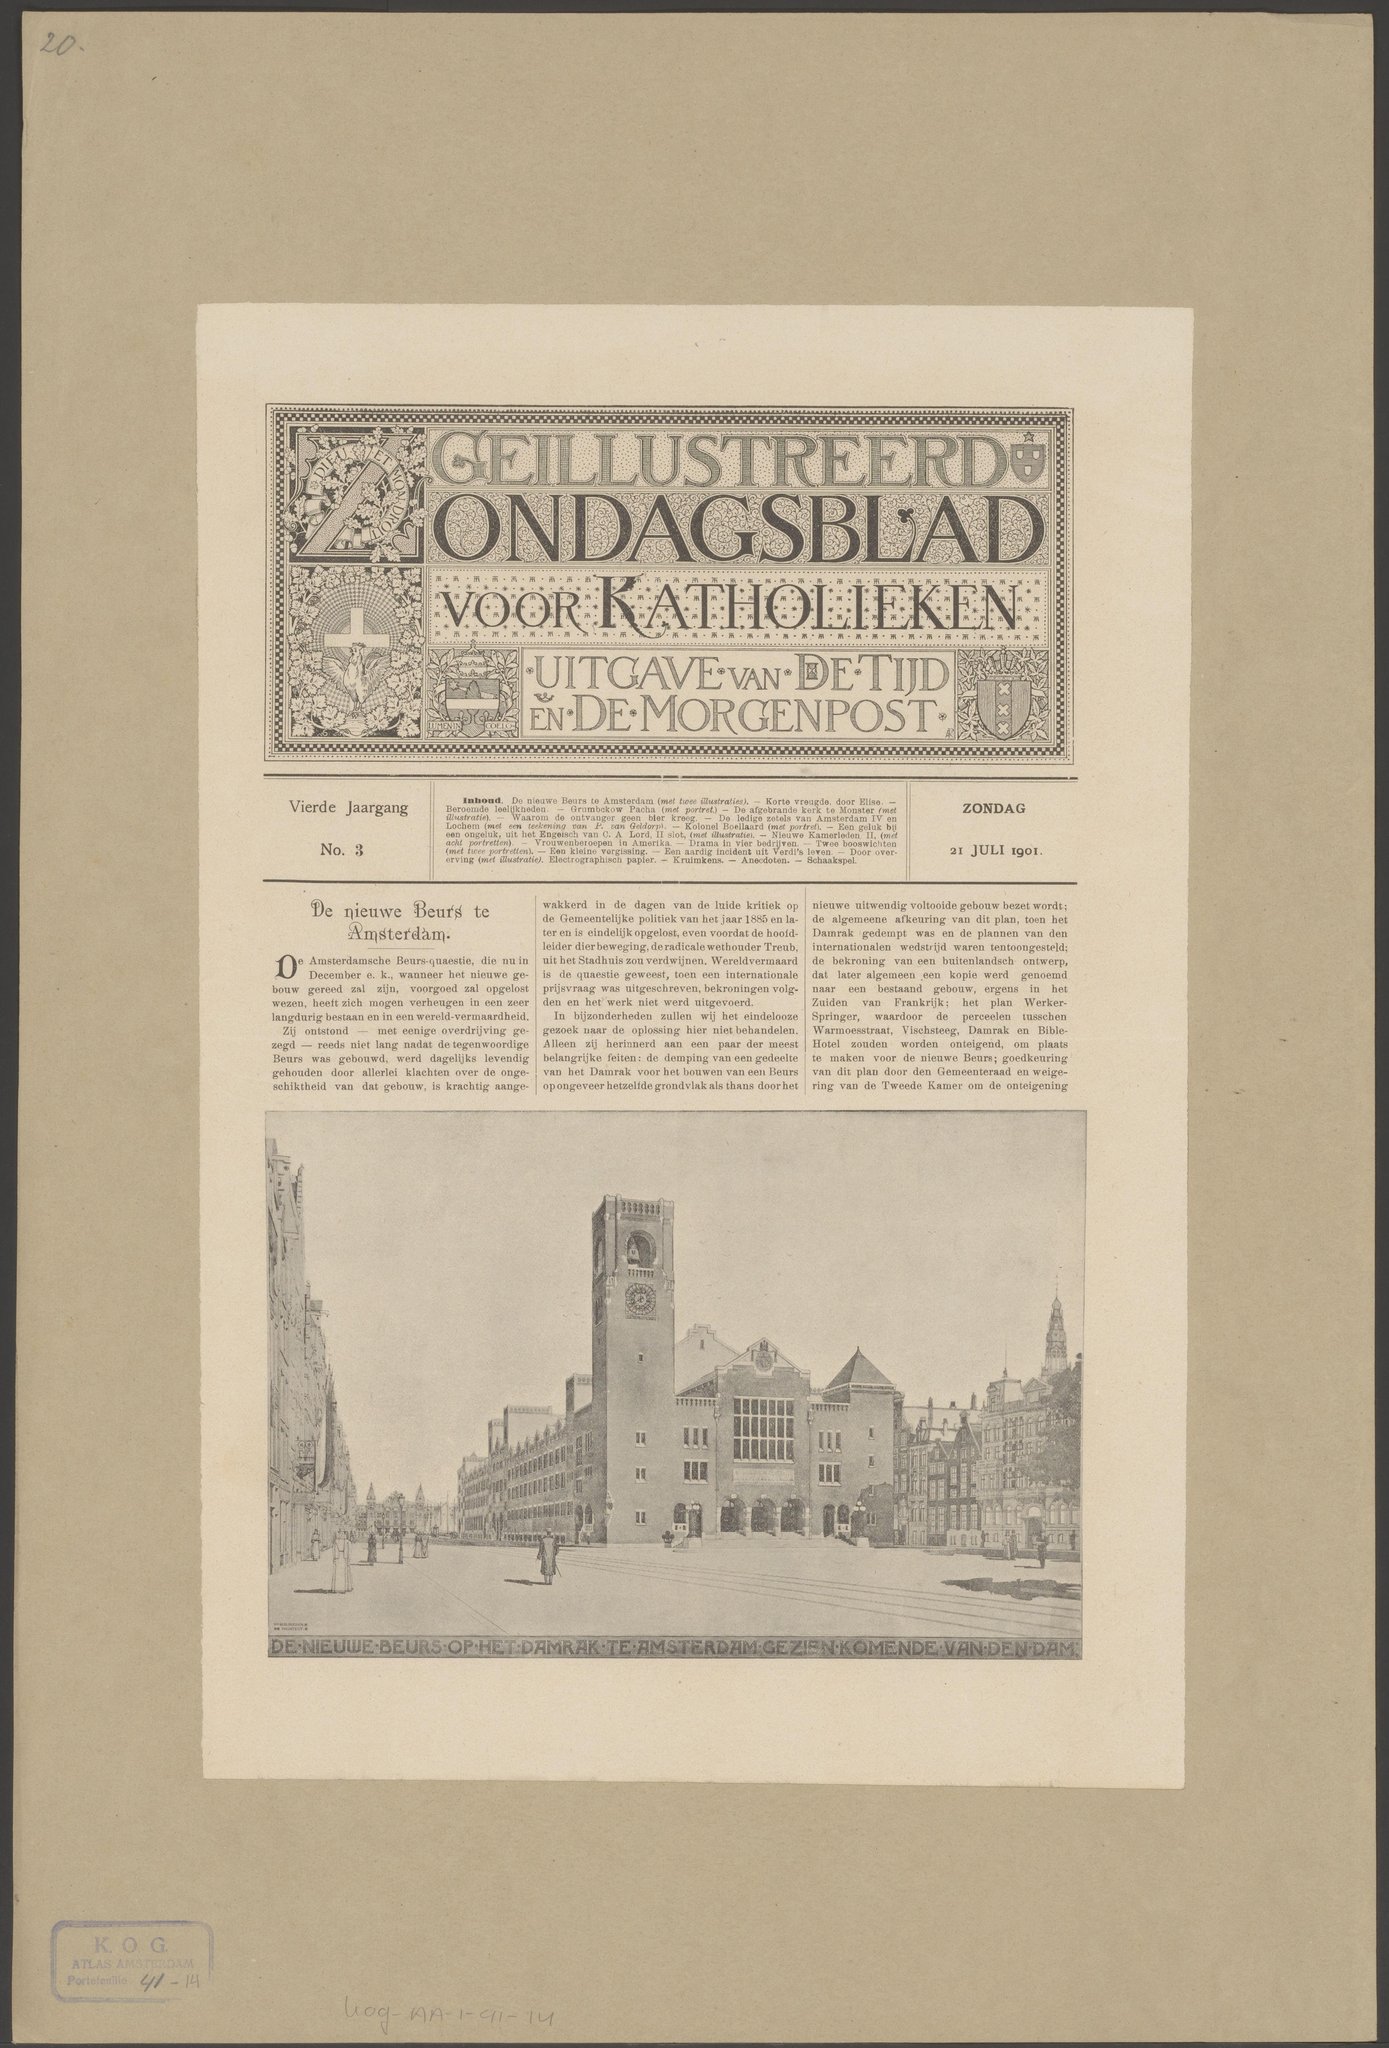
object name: photomechanical print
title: Gezicht op Beurs van Berlage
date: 1901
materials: paper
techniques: letterpress printing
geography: amsterdam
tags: stock exchange, stock-market, amsterdam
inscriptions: collector's mark: Lugt 1461b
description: Titelpagina voor: Geïllustreerd Zondagsblad voor Katholieken 4 (1901), n. 3, 21 juli 1901.